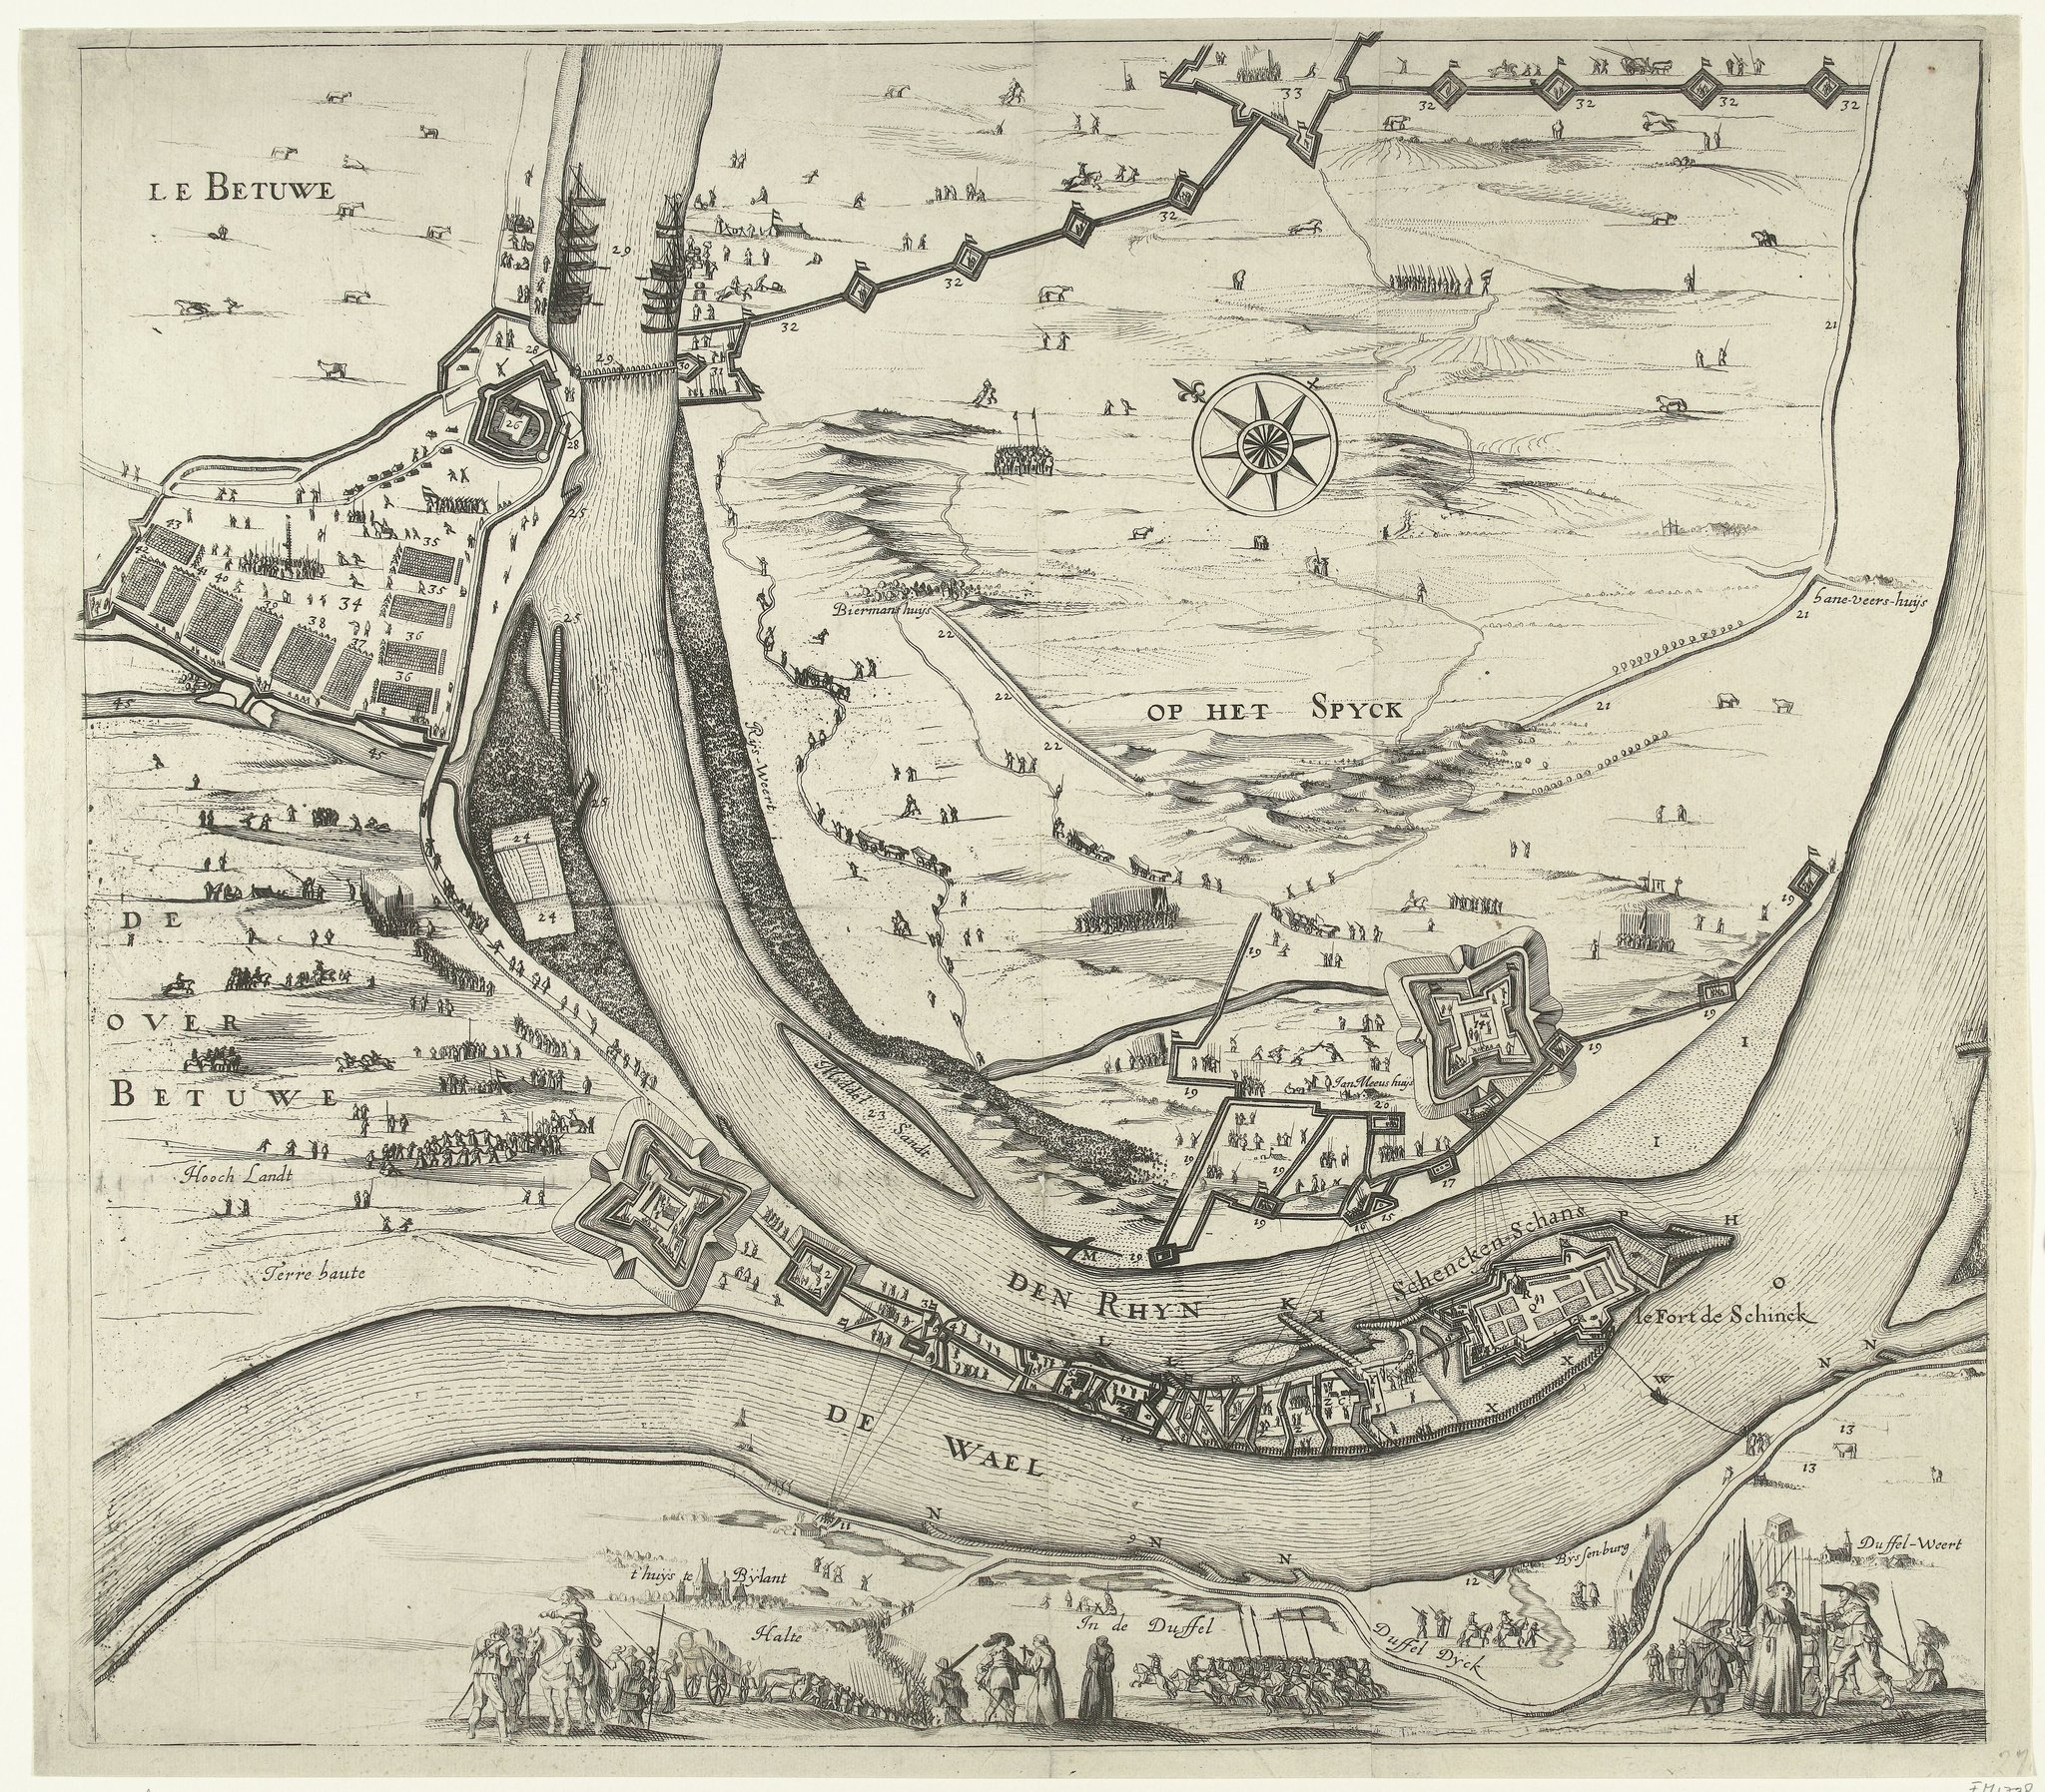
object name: print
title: Belegeringe van Schencken-Schans, Met alle de nieuwe Forten ende Approchen / le Siege du Fort de Schinc, Avecq toutes les Nouvelles Fortifications et Approches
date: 1635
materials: paper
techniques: engraving, etching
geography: the hague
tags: maps of separate countries or regions, capture of city (after the siege)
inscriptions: date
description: Middenblad van de kaart van het beleg van het door de Spanjaarden op 28 juli 1635 bij verrassing ingenomen fort Schenckenschans door het Staatse leger onder Frederik Hendrik, sinds 30 juli 1635. Kaart van het rivierengebied met de Schenckenschans op de splitsing van de Rijn en Waal. Middenblad in een ongemonteerd geheel bestaande uit drie platen en twee tekstbladen.